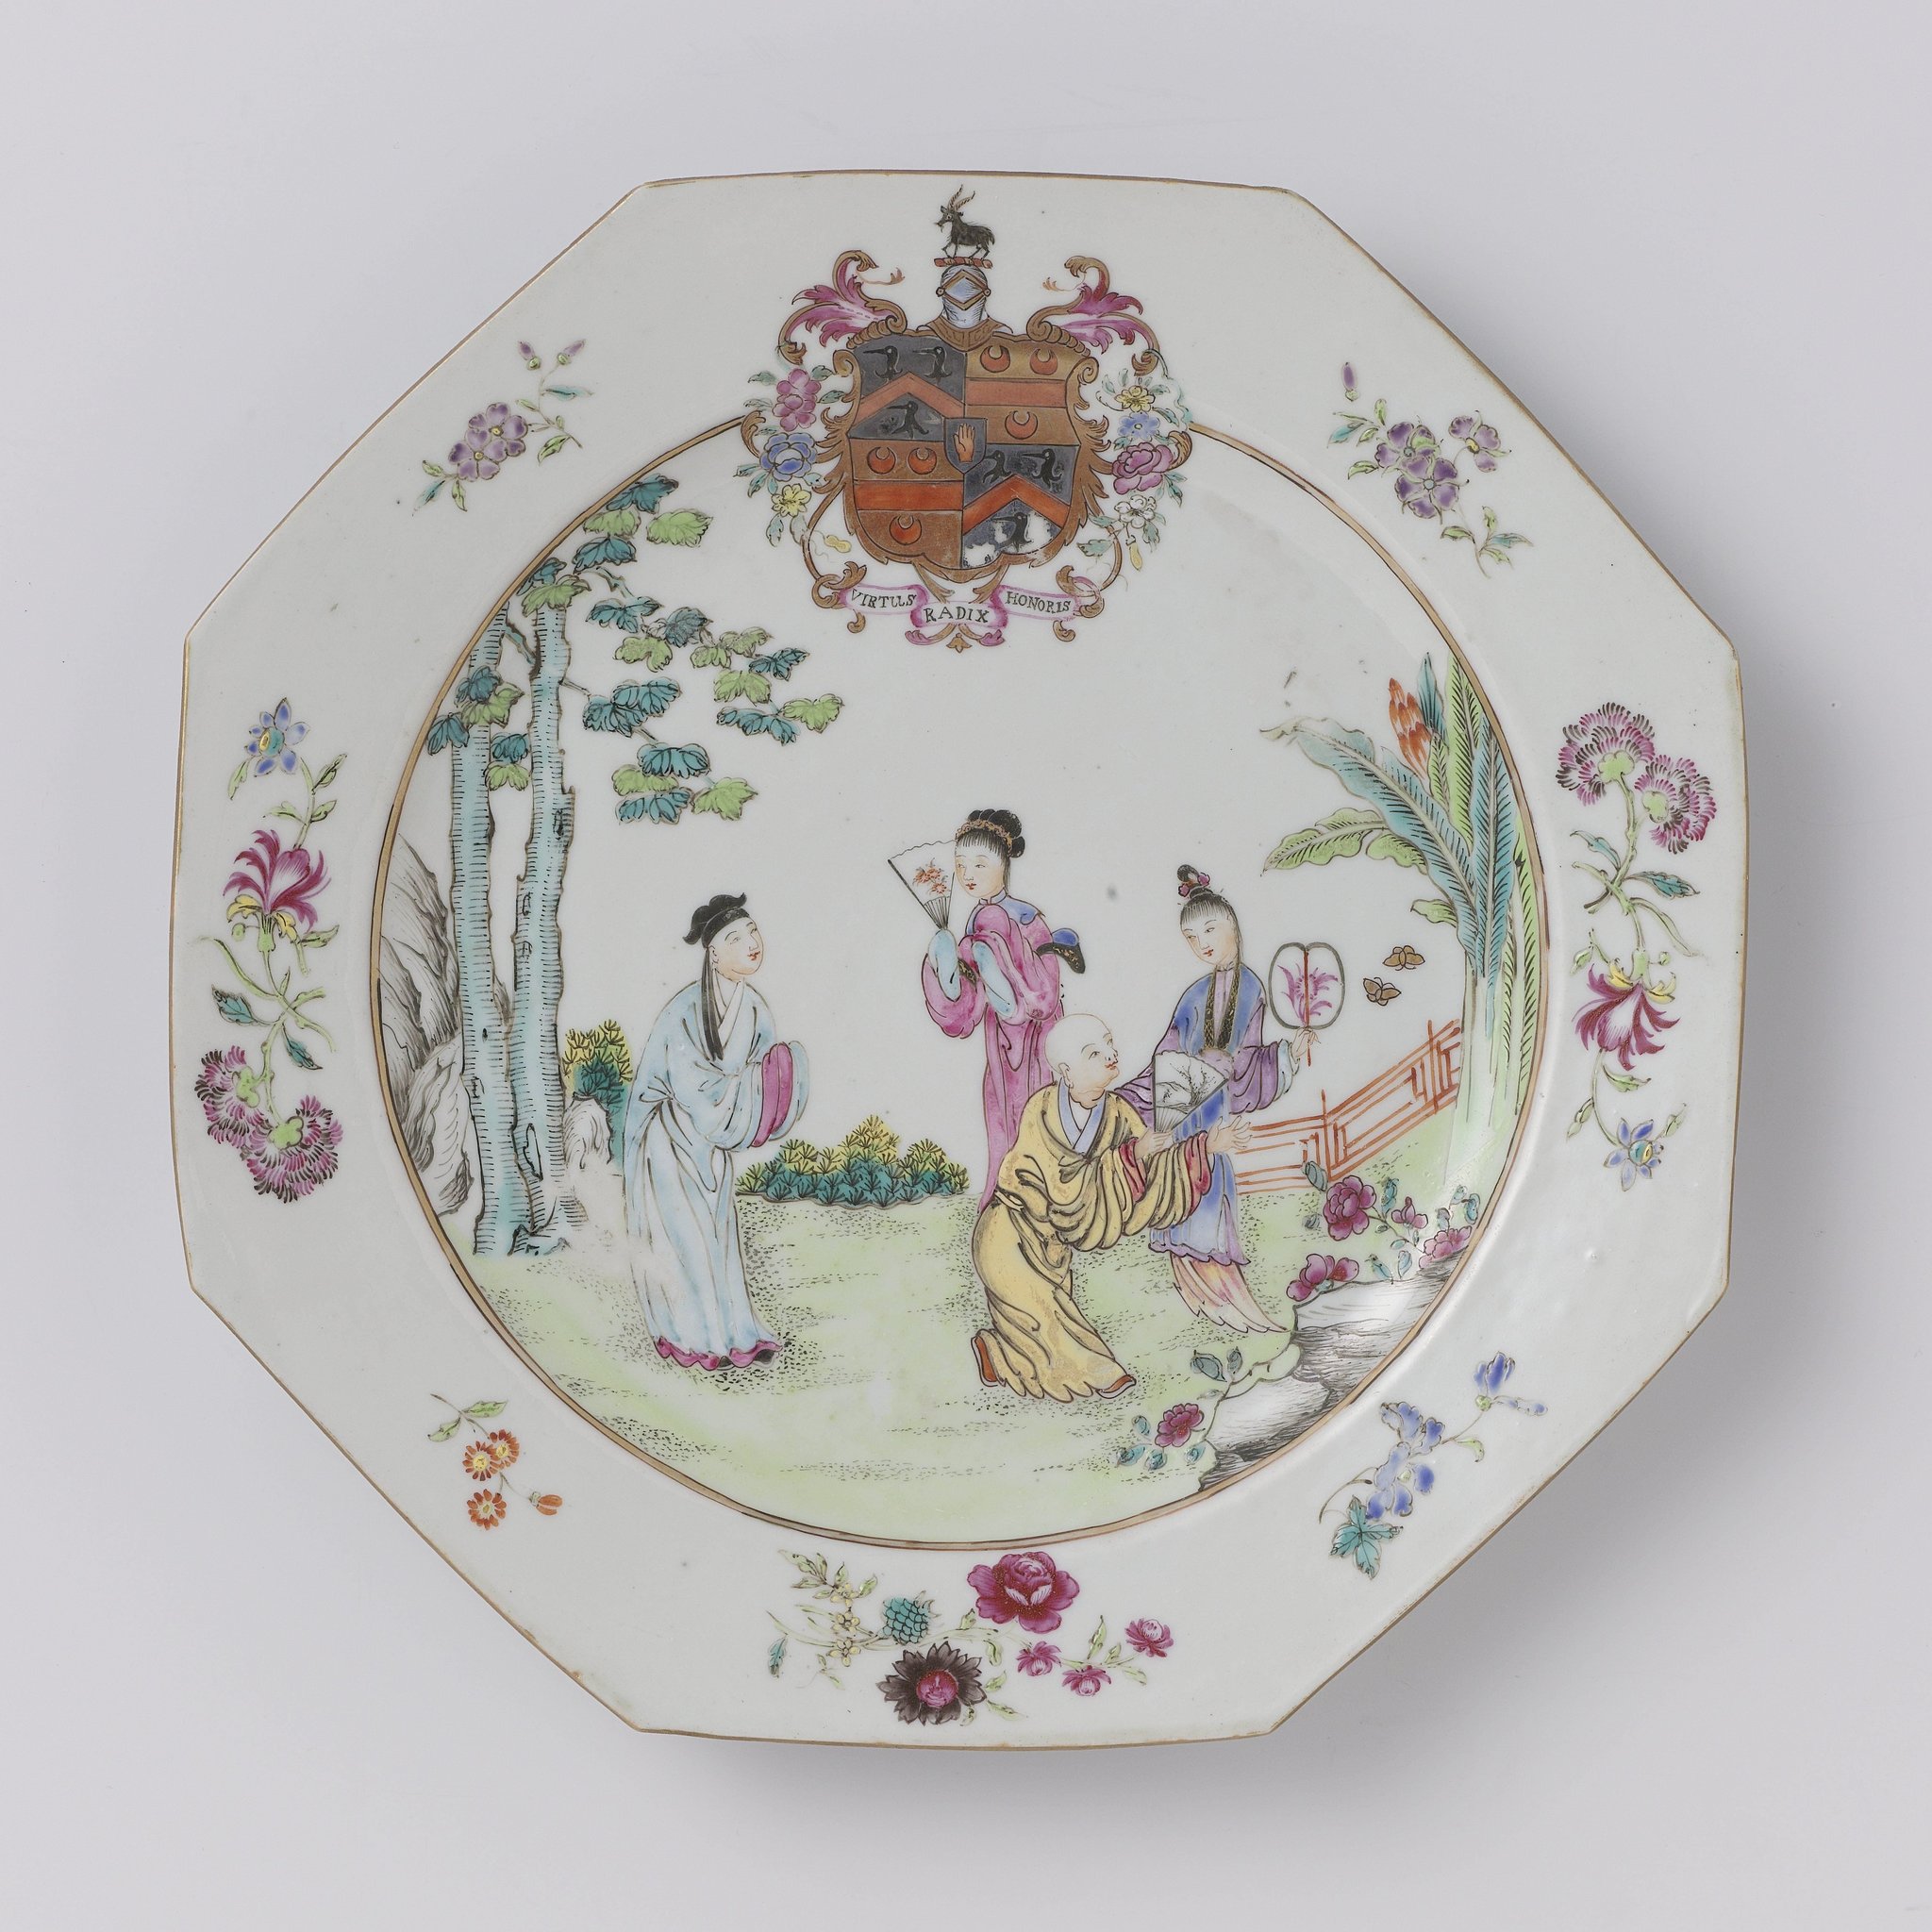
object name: plate dish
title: Octagonal plate with the arms of the Boynton and Topham family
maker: Anonymous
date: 1740-1760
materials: glaze, gold, paint, porcelain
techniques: firing, forming, gilding, turning, vitrification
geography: china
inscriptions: label: ‘Boynton Collection/ no. 1029’, inscription: ‘VIRTUS RADIX HONORIS’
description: The two figures in the background are the lovers Cui Yingying and Zhangsheng, who are reunited here after an unhappy period. Their misfortune was caused by a general intent on forcing Yingying to marry him. To save her, a letter from Zhangsheng was delivered to another general, who came to her rescue.